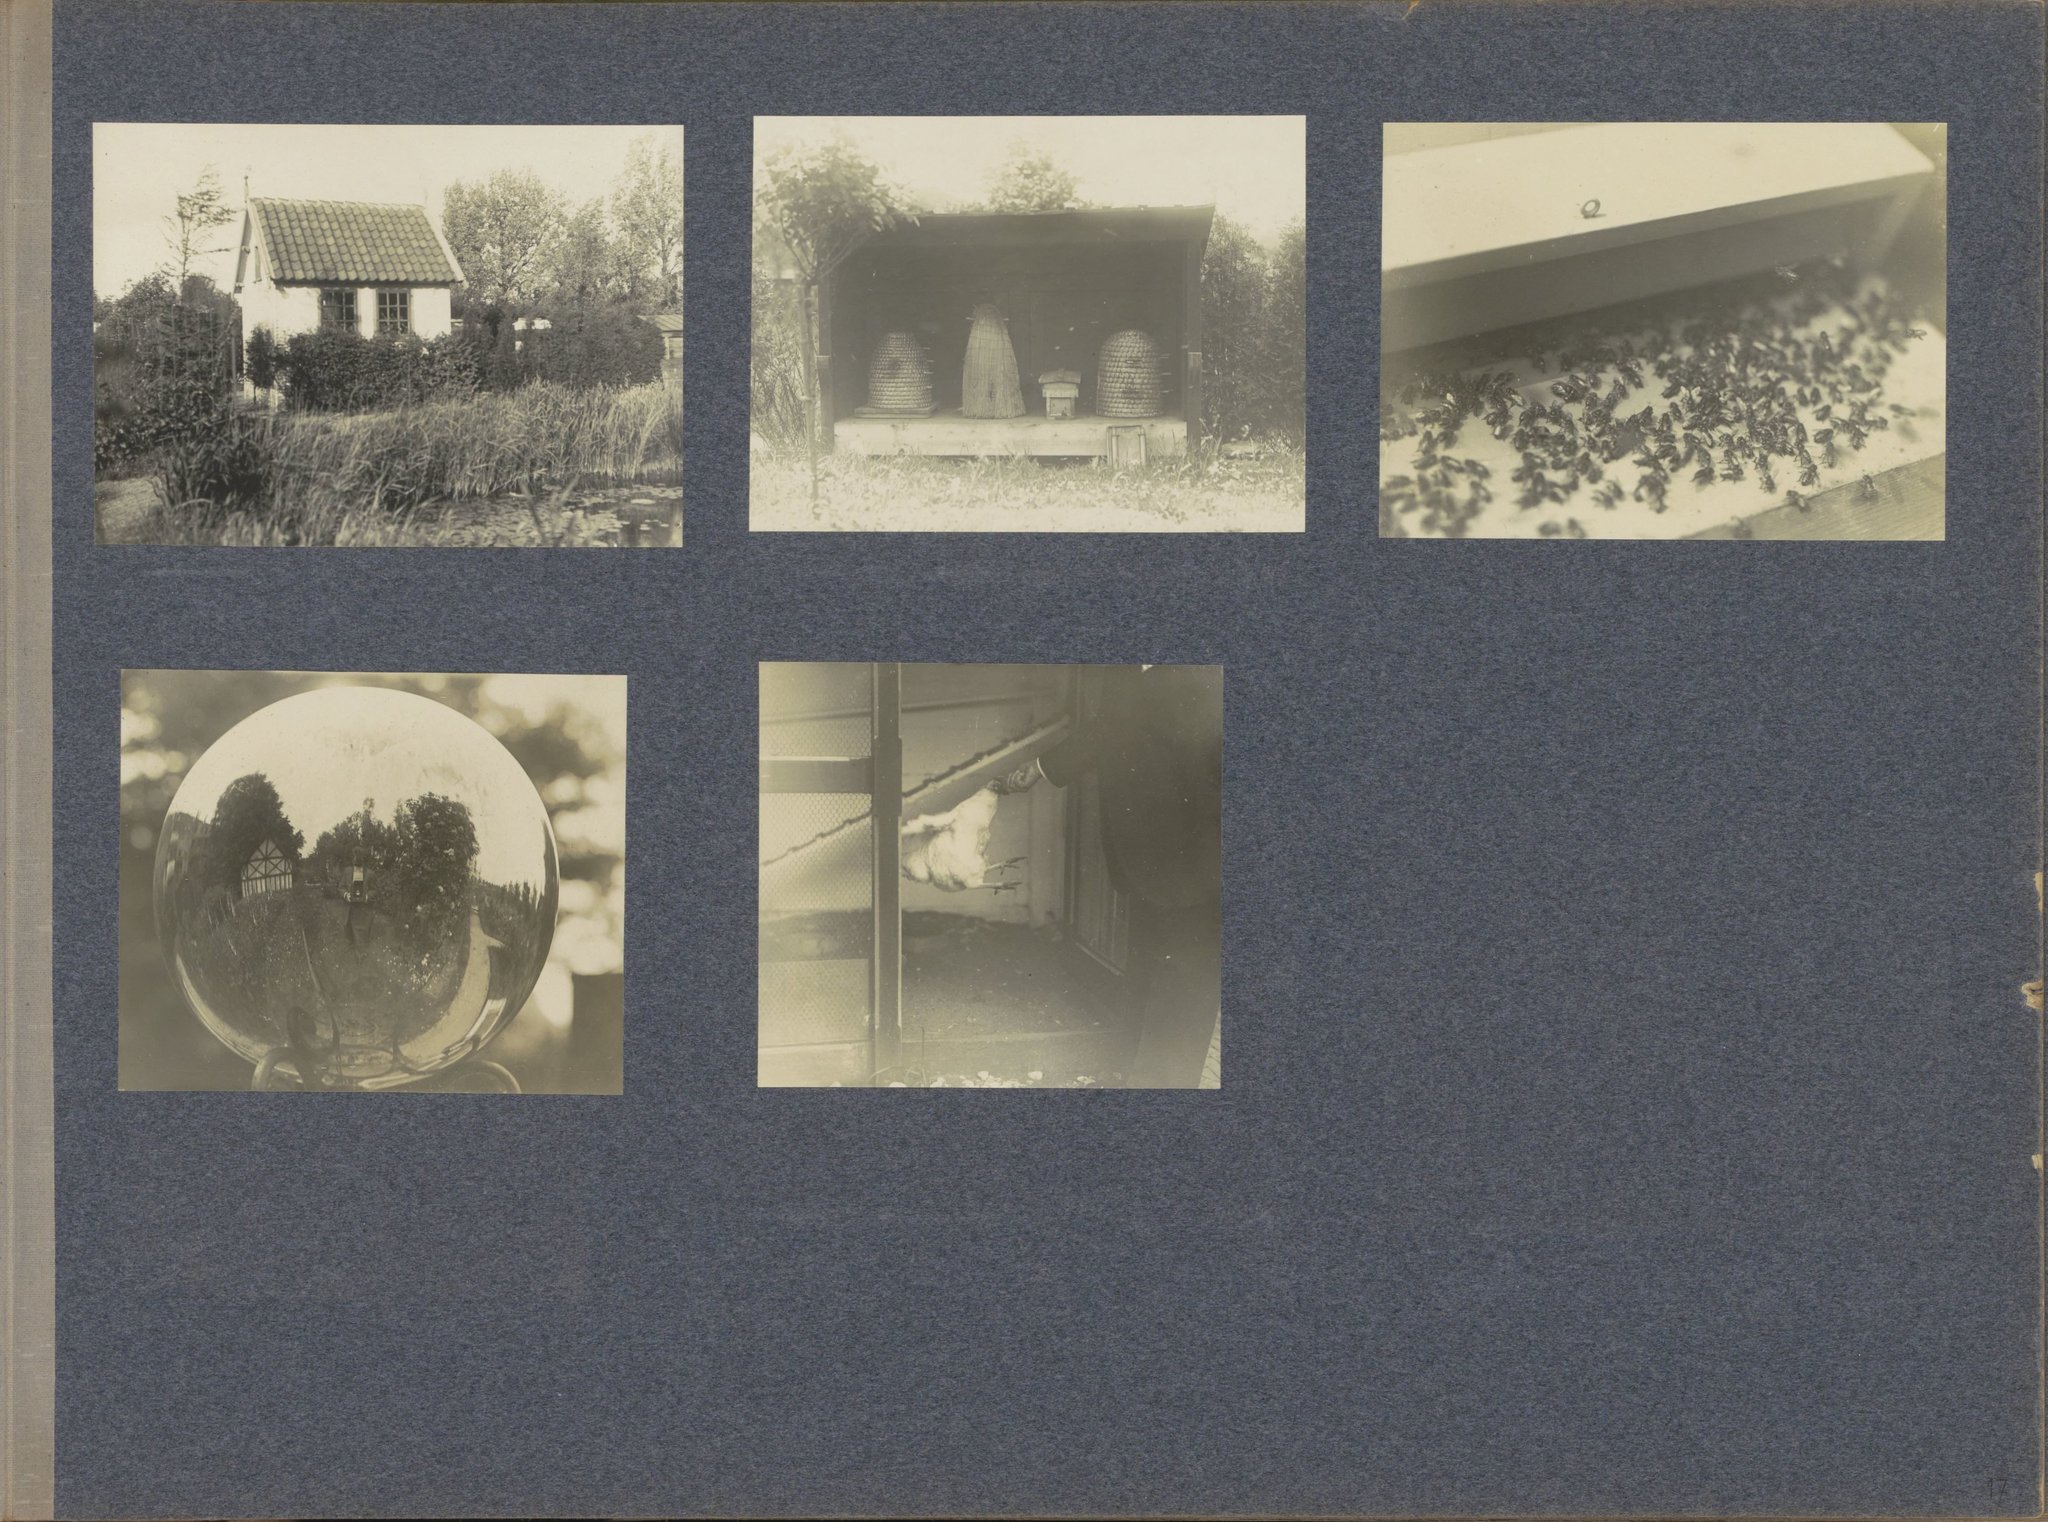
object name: album leaf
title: Tuin met bijen en zelfportret van een fotograaf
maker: Anonymous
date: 1910-1911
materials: cardboard, paper, photographic support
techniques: gelatin silver print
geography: netherlands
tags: photographer at work - cc - out of doors, garden, bee-hive, portrait, self-portrait of photographer, netherlands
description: Albumblad met vijf foto's van een tuin met bijenkorven en van een kip die de nek wordt omgedraaid. Ook een opname van een (vermoedelijk) metalen bol waarin de fotograaf staand in een tuin wordt weerspiegeld. Onderdeel van Fotoalbum van de familie Palthe uit Almelo.